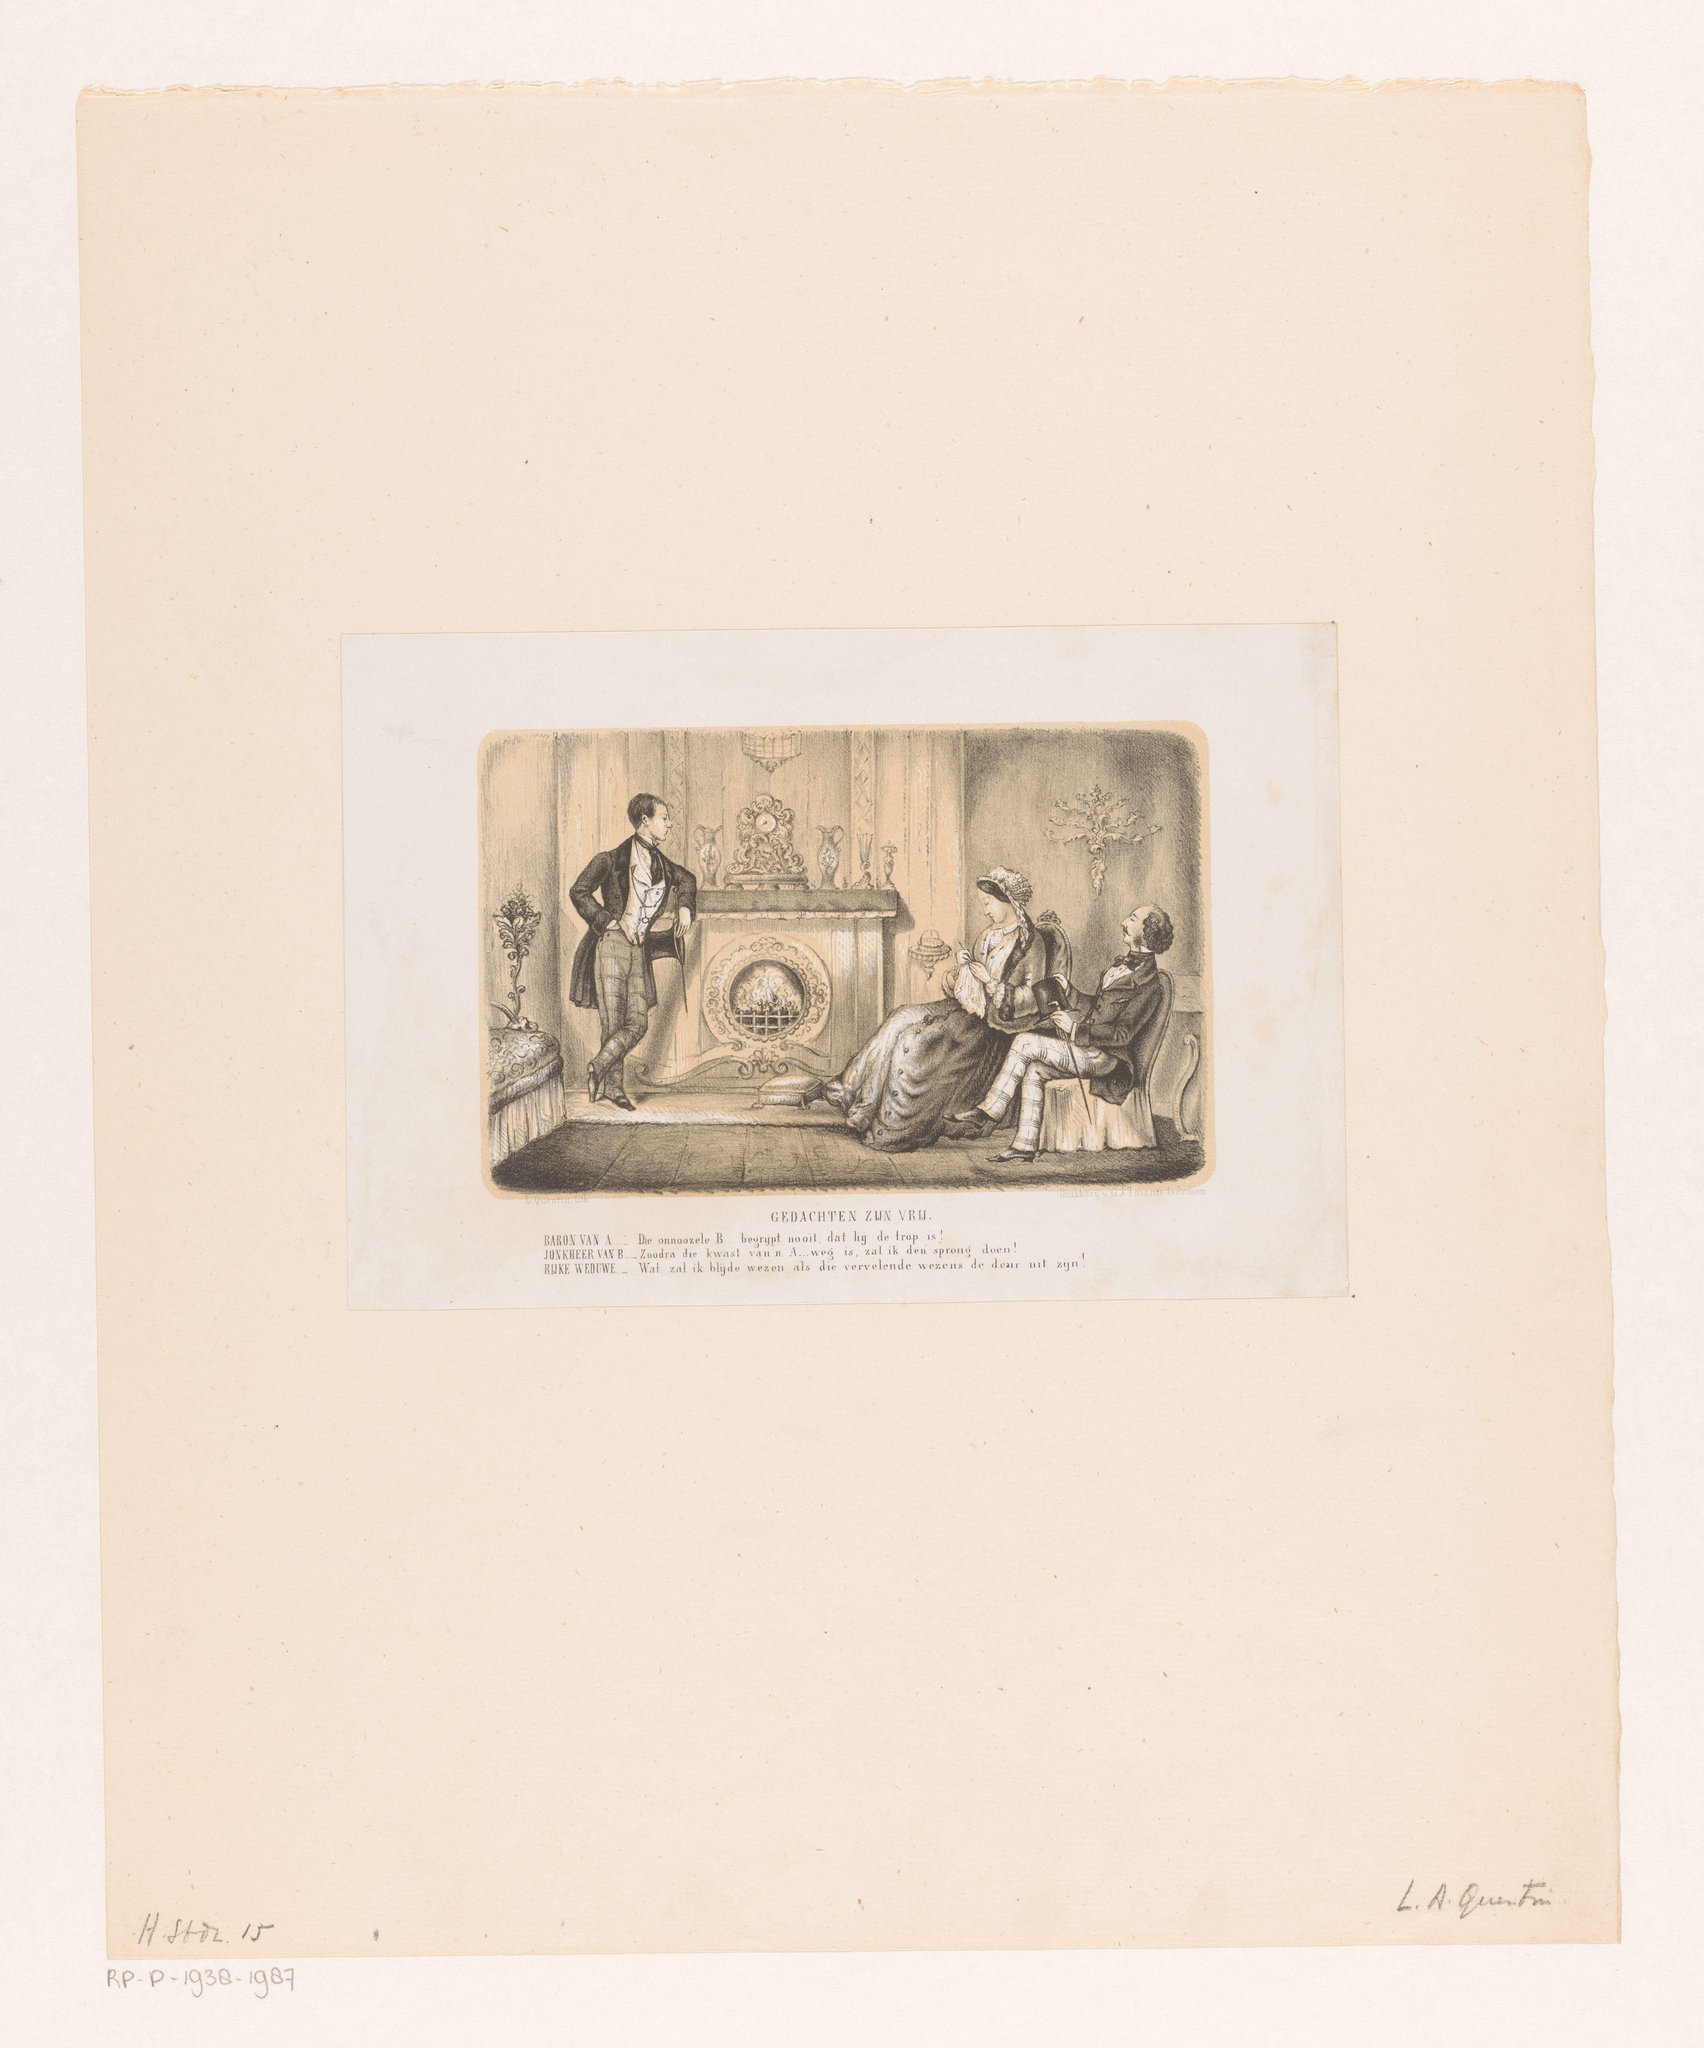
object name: print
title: Twee mannen en weduwe in interieur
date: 1856-1889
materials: paper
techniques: tone lithography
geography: arnhem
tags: thinking, thought, reflection; 'pensiero' (ripa)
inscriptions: collector's mark: Lugt 2228, collector's mark: Lugt 2760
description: Een jongeman met hoge hoed in zijn hand staat tegen het bovenstel van een haard geleund. Rechts zitten een bordurende weduwe en een man met hoge hoed in de hand. In de ondermarge een tekst met de gedachten van de drie figuren.